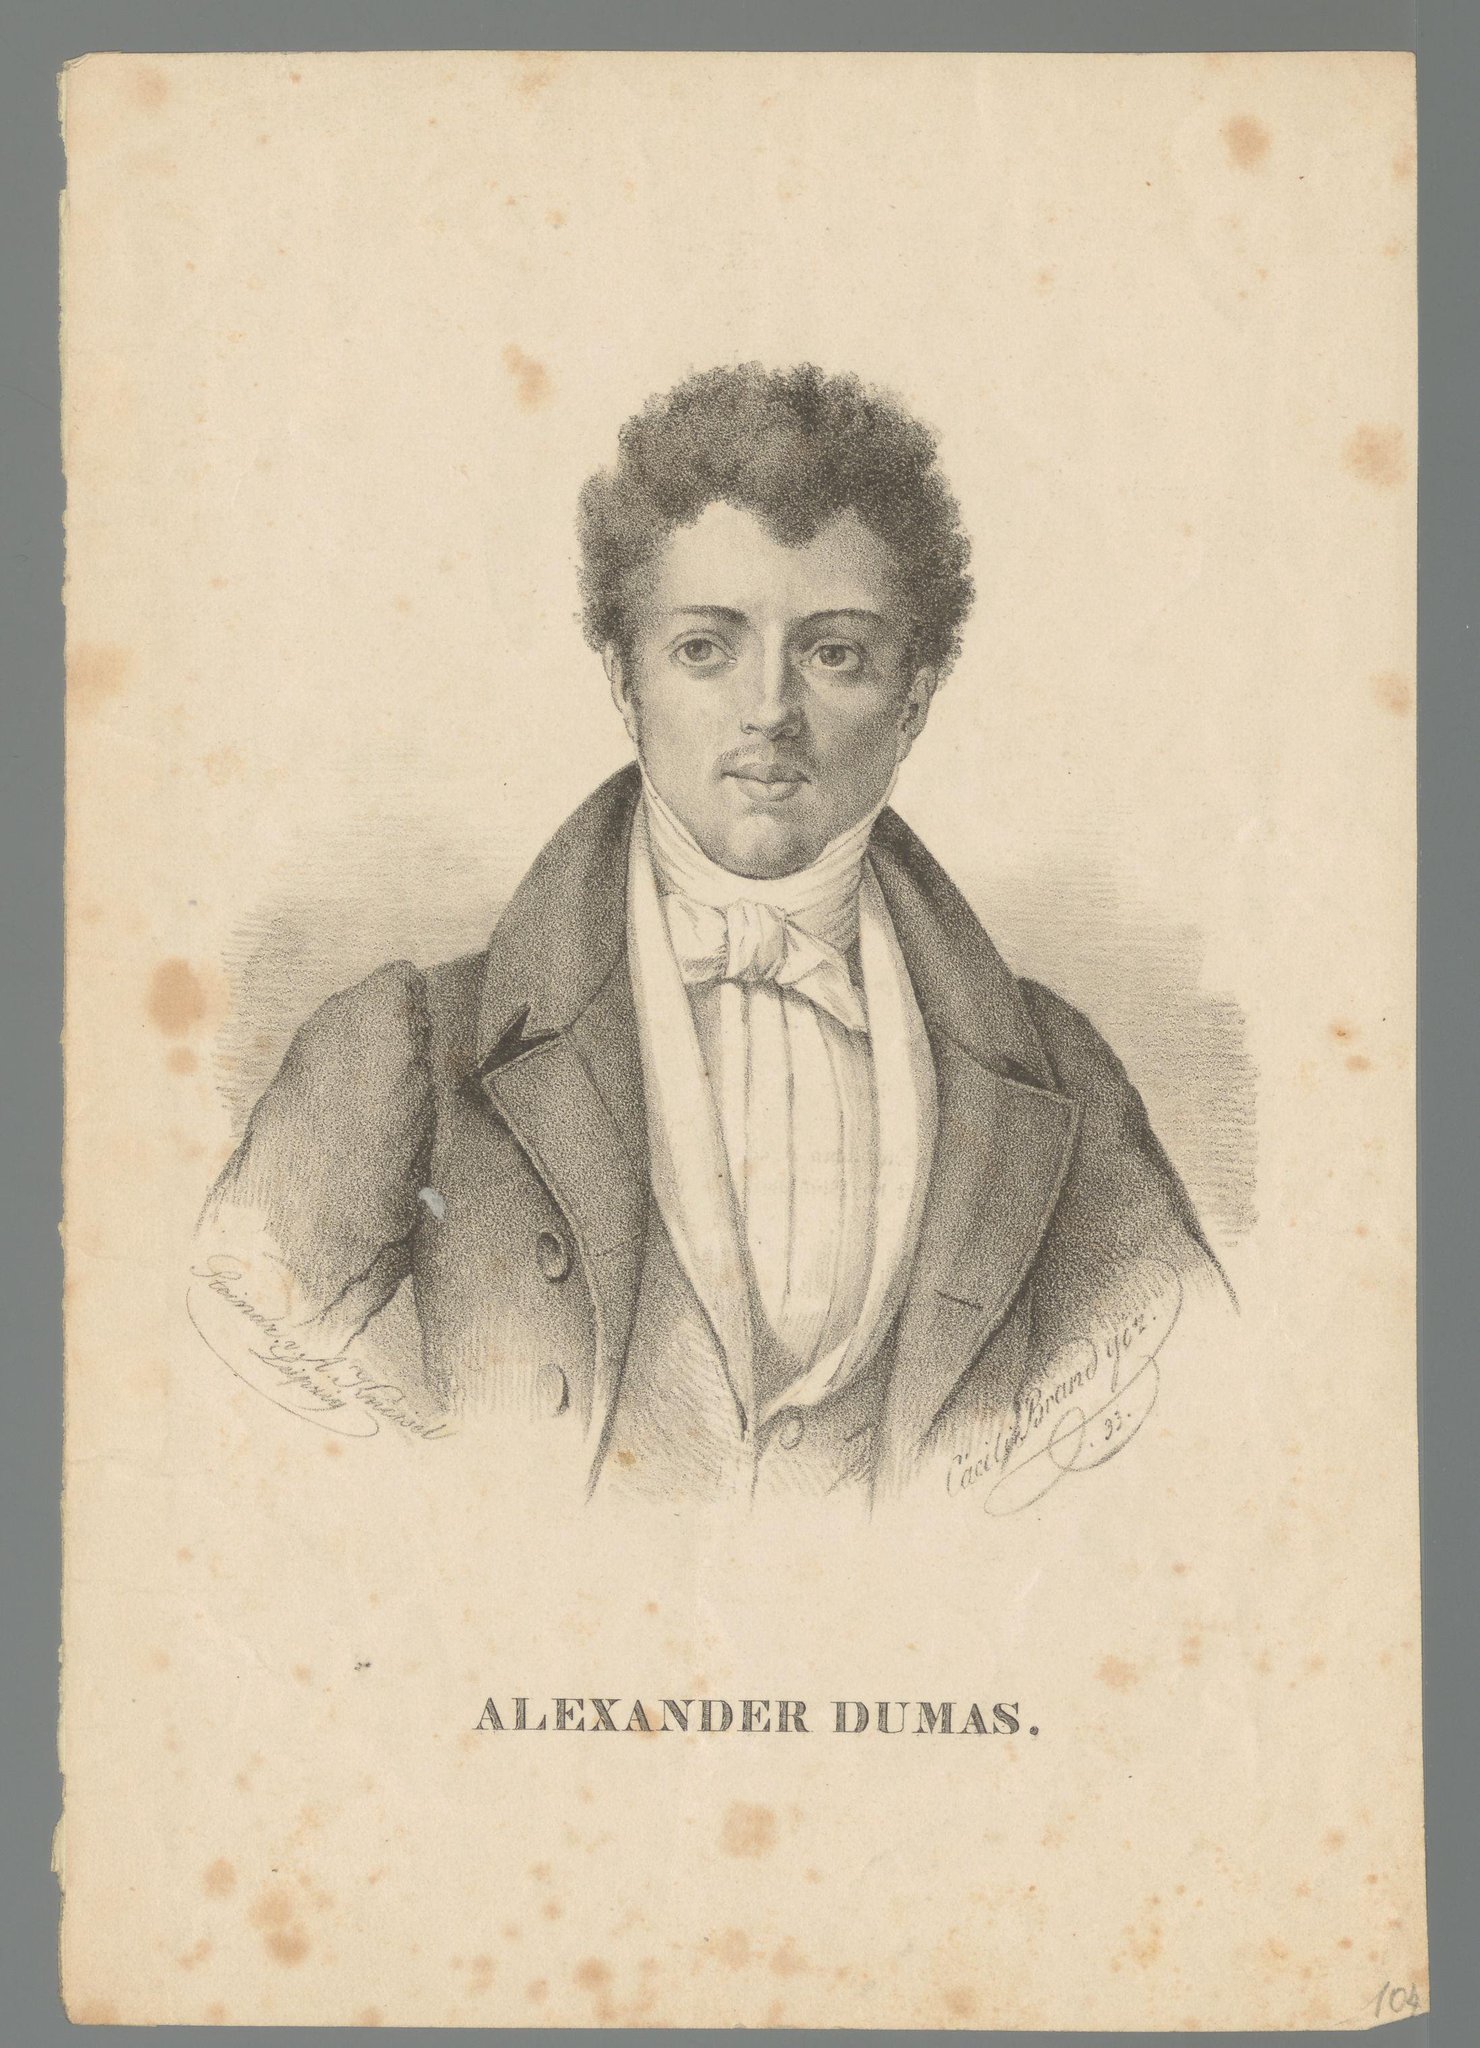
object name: print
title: Alexander Dumas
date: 1833-1839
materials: paper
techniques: lithograph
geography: leipzig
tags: adult man, historical persons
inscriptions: inscription: ‘Portr. 61600/ Dumas LB XXIV 446078’, collector's mark: Lugt 2760, collector's mark: Lugt 2228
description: De schrijver Alexander Dumas (1802-1870). Buste van voren gezien.